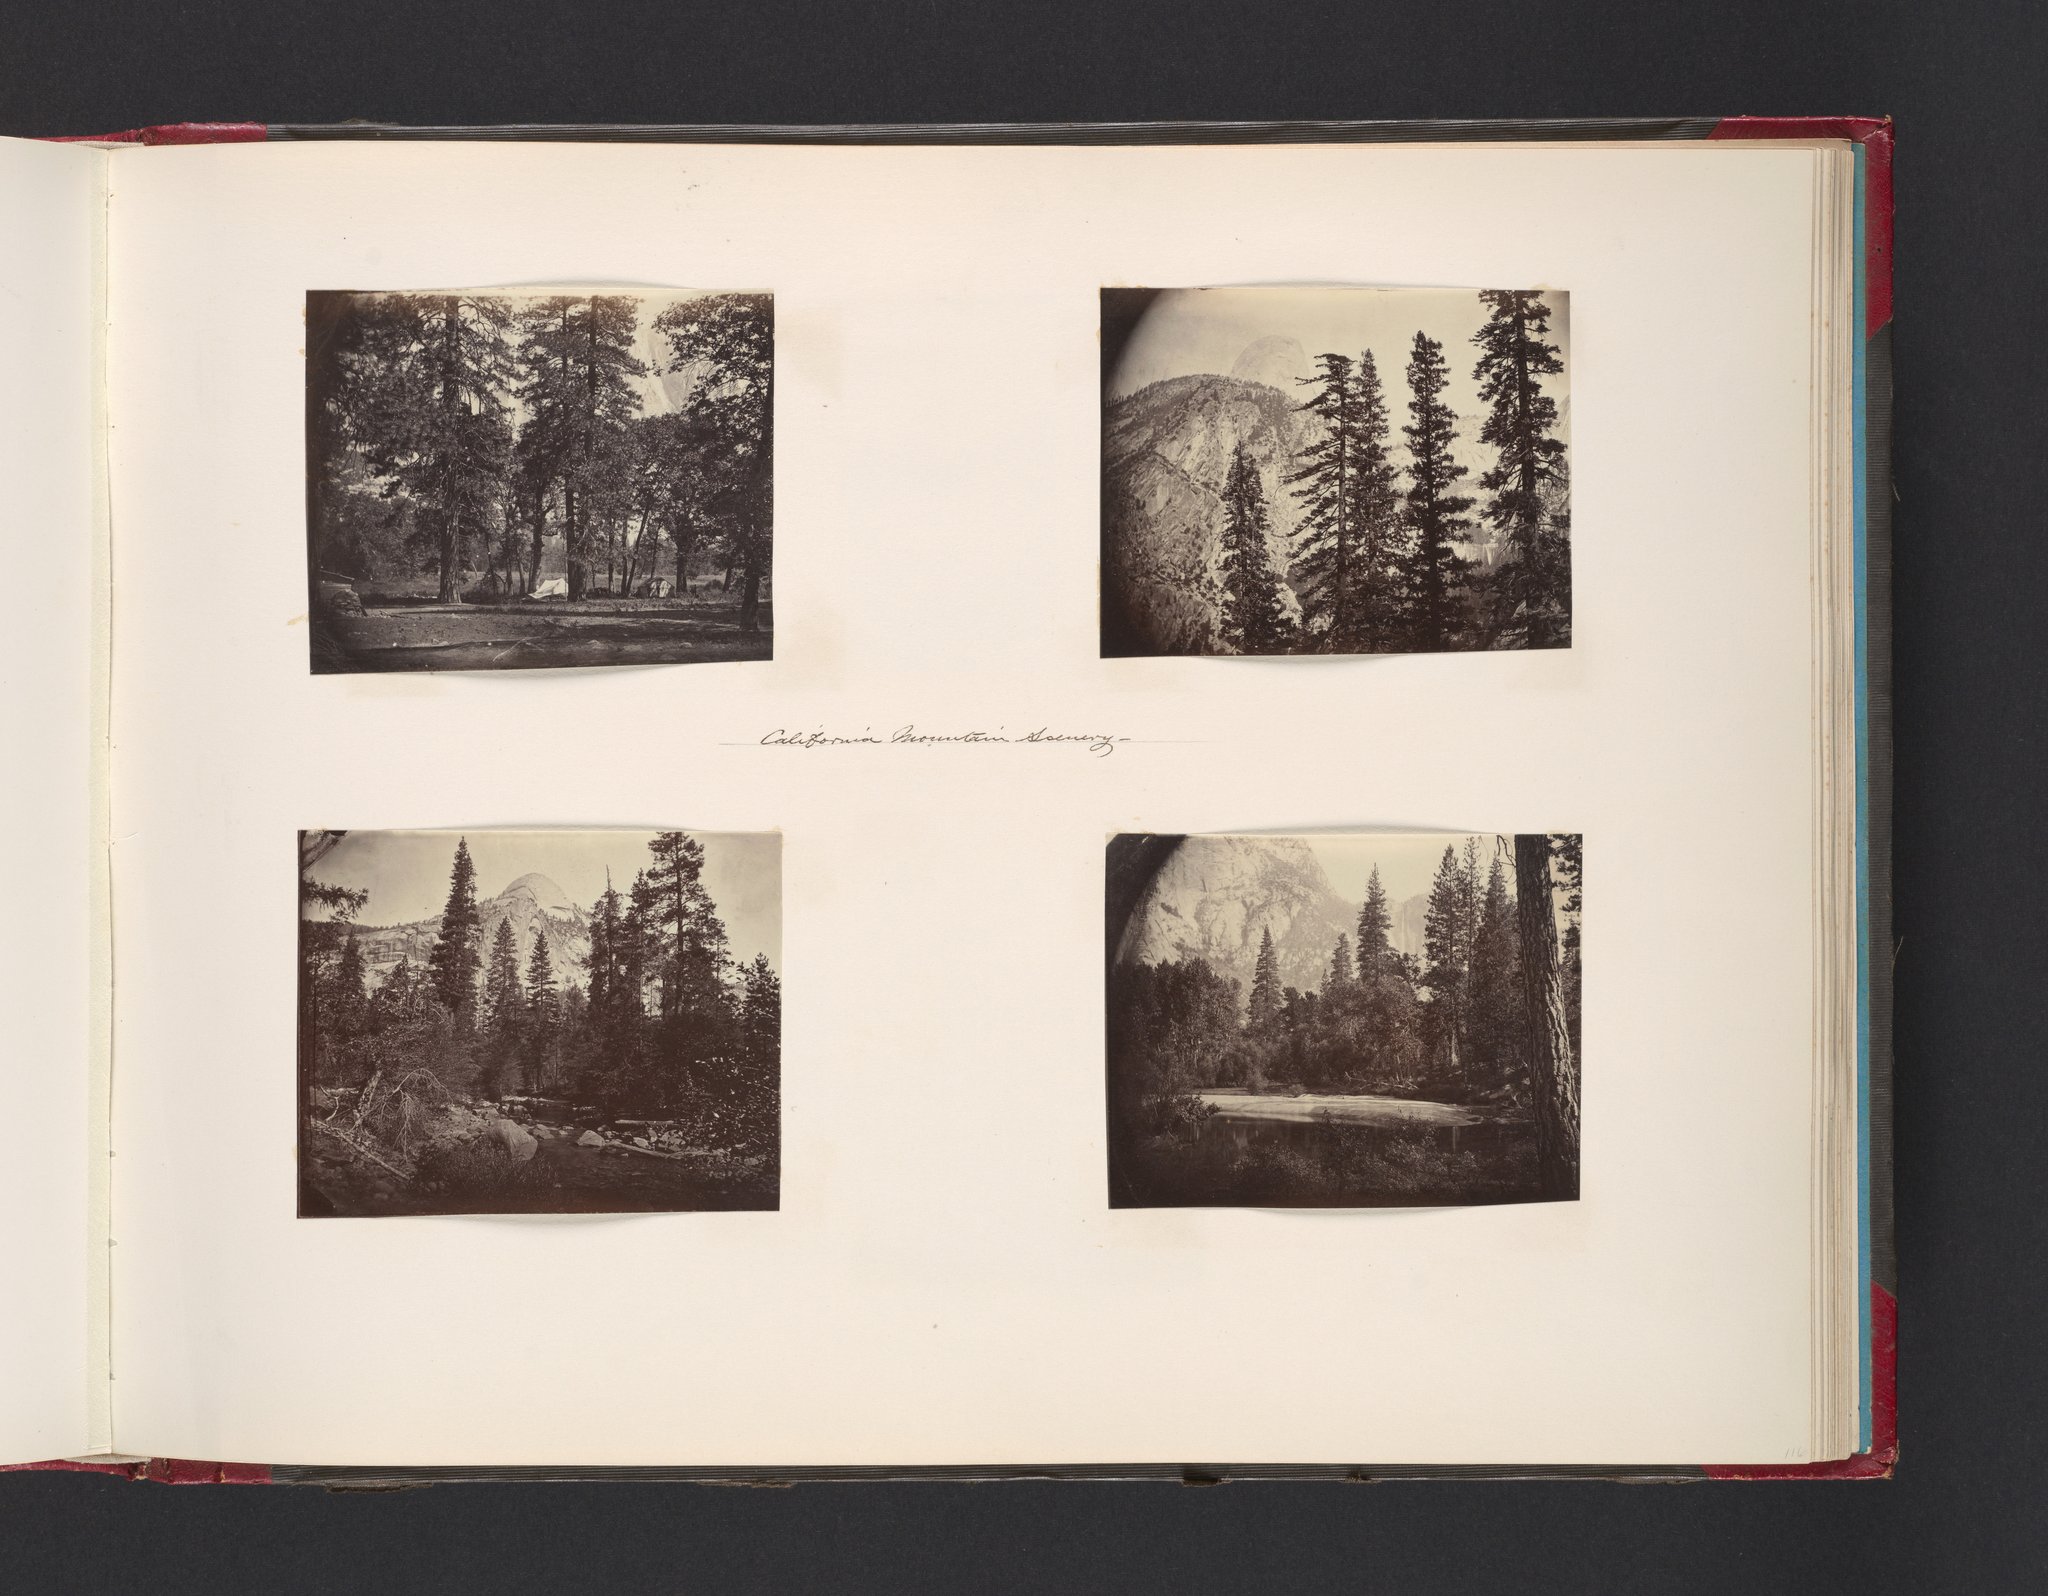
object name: photograph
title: California Mountain Scenery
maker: john thomson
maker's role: artist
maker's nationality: british, scottish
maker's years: 1837-1921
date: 1865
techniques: albumen silver print, glass negative